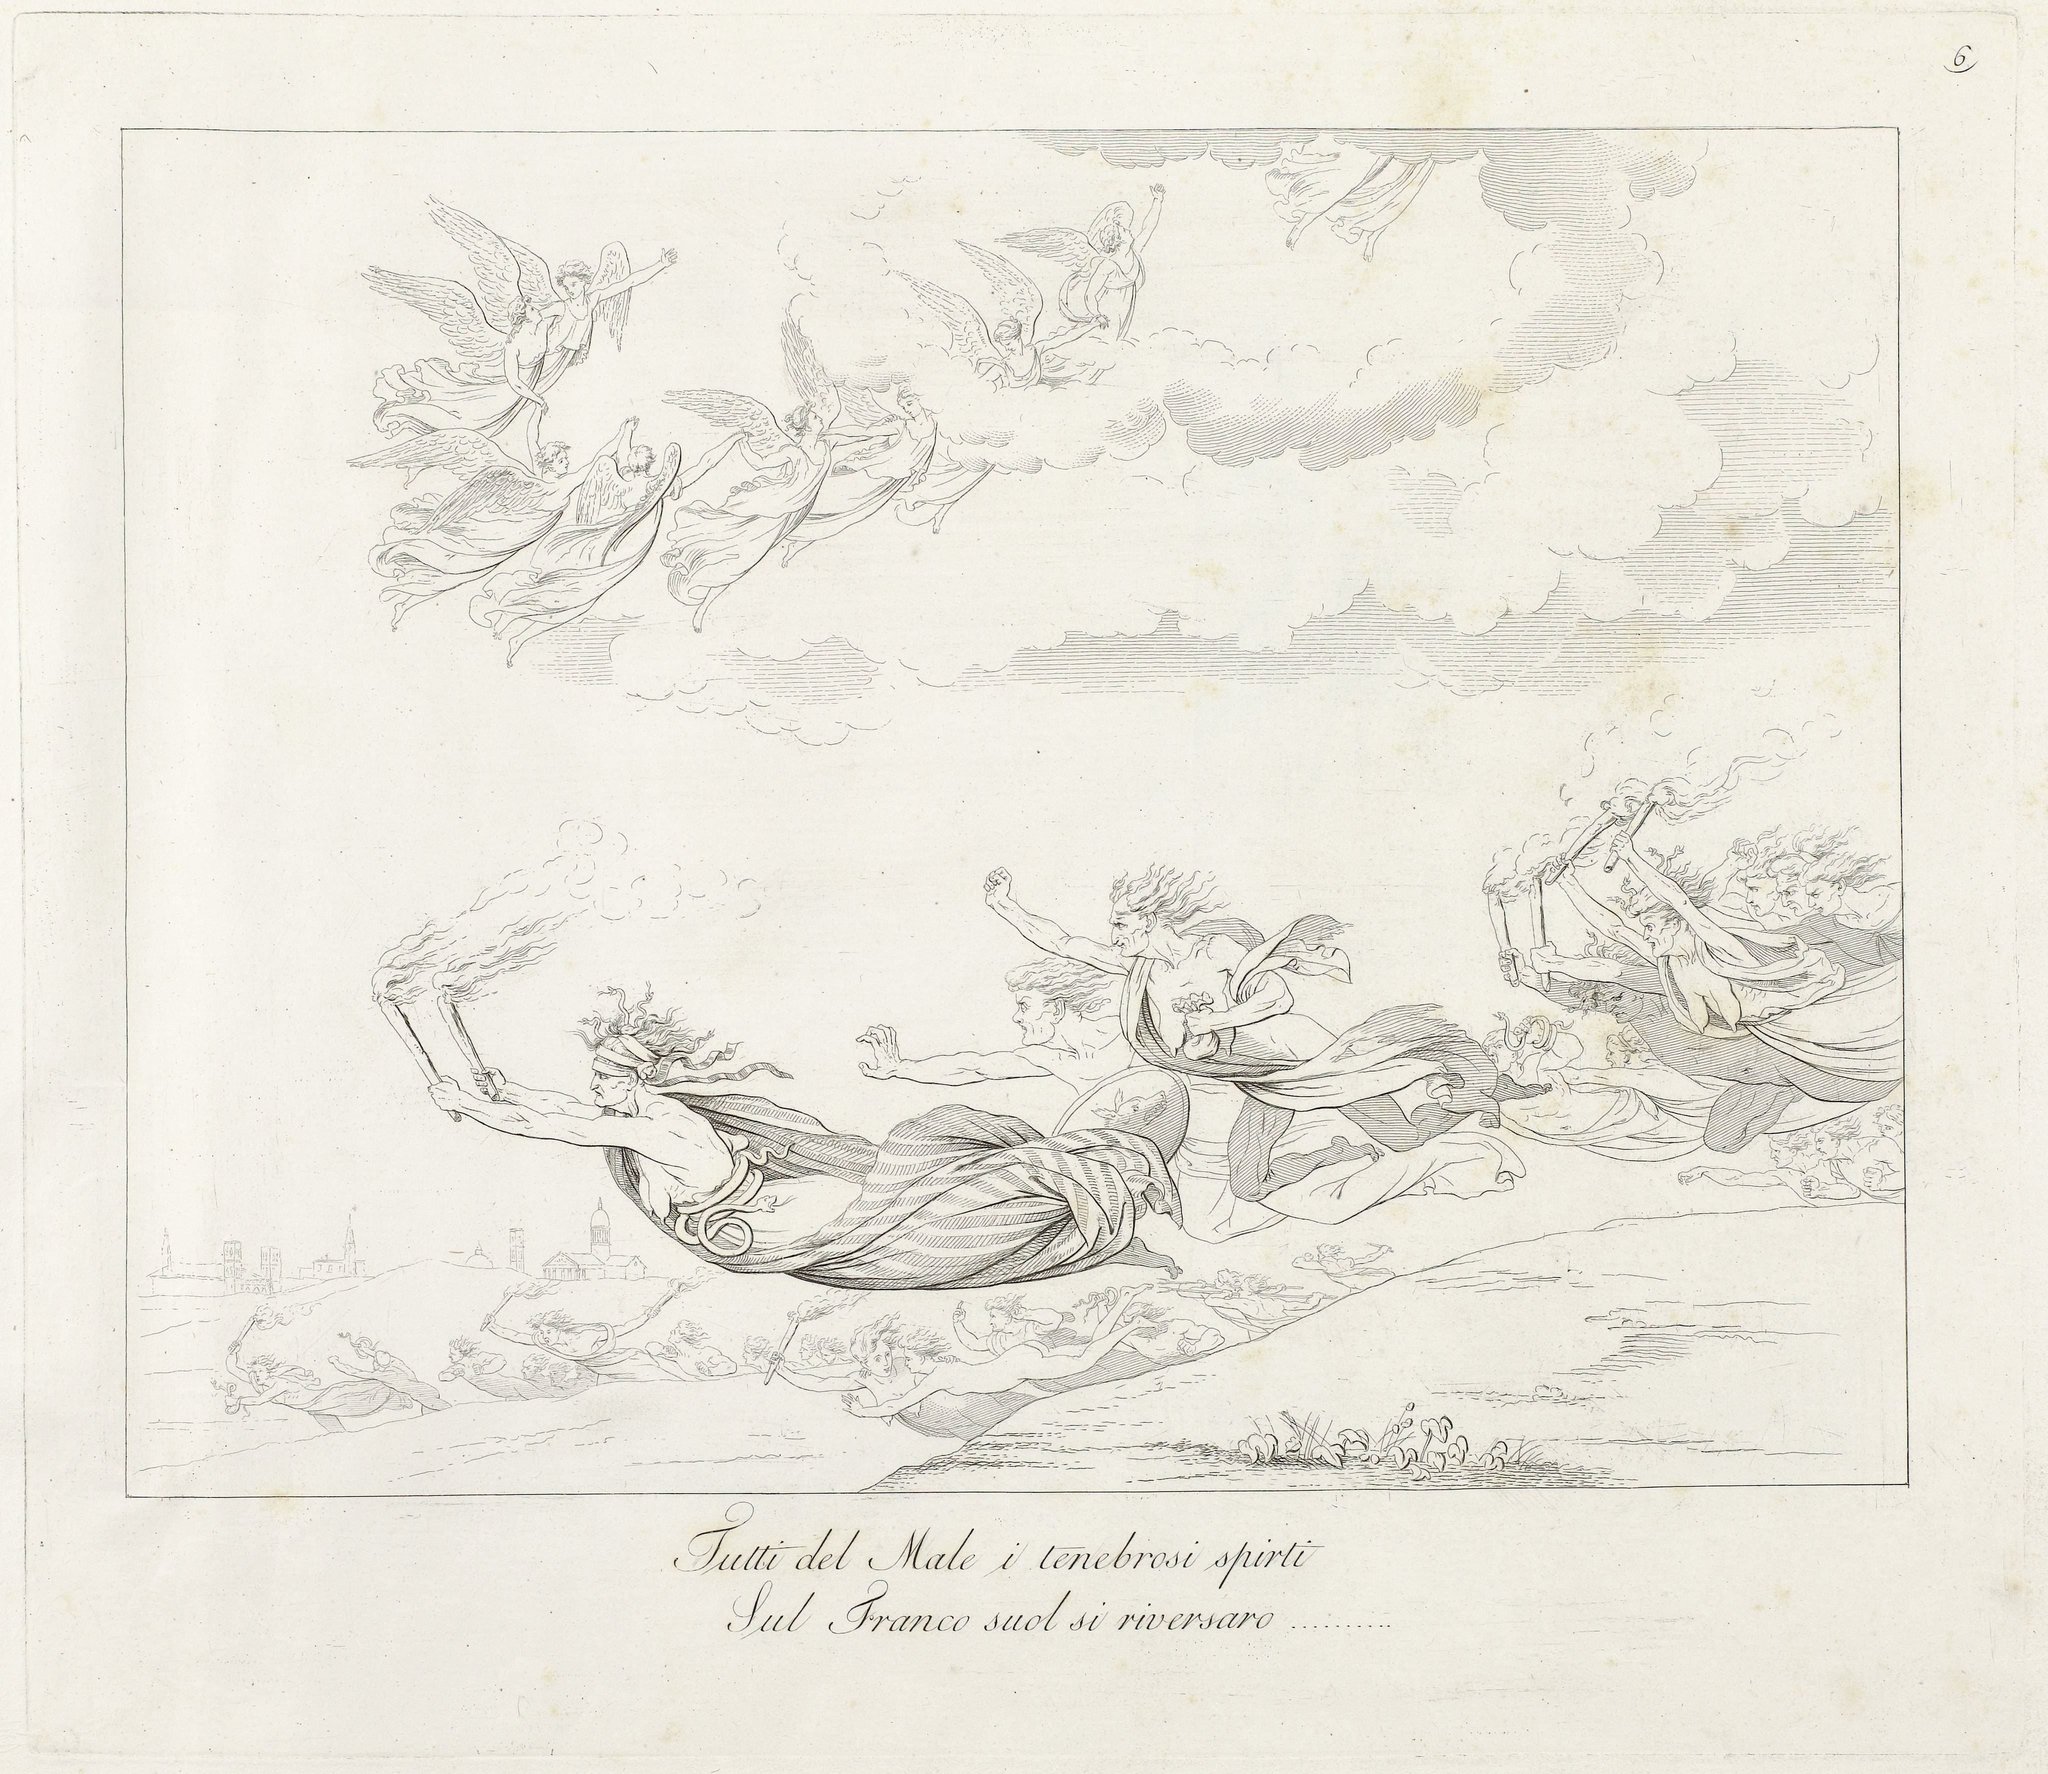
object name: album leaf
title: La pronea del Cesarotti delineata ed incisa dal Matteini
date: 1808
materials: paper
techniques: etching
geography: italy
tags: napoleon i (emperor of the french), monsters of mixed human and animal shape; 'mostri' (ripa) (+ hair, feathers), torch (+ kindling a light; lit, burning light, lamp, candle), angels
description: Onder de voorstelling een versregel in het Italiaans. Prent maakt deel uit van een album.